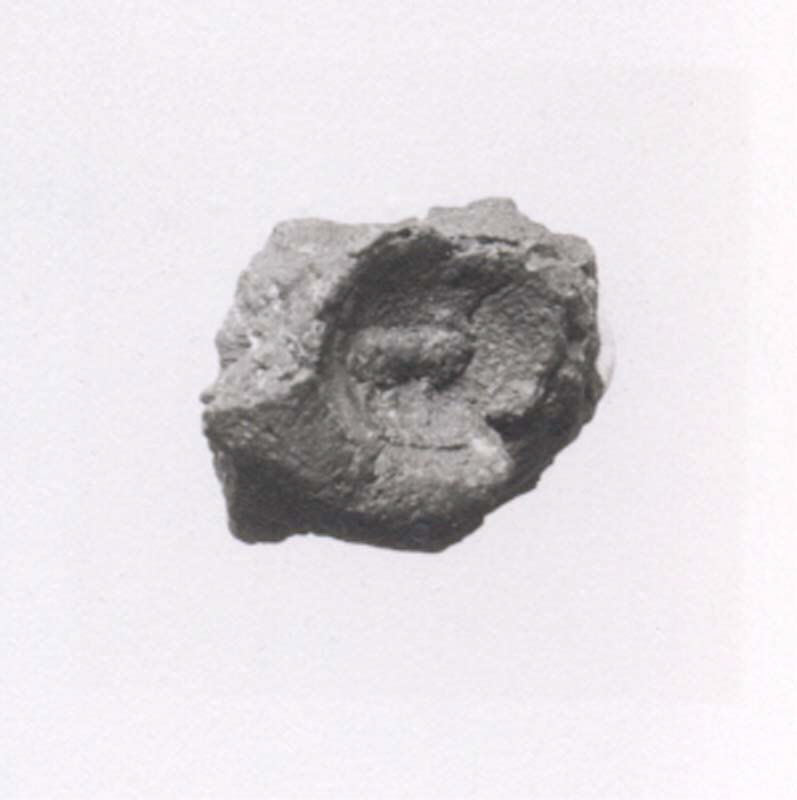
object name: sealing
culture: sasanian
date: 601-700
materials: clay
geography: iran